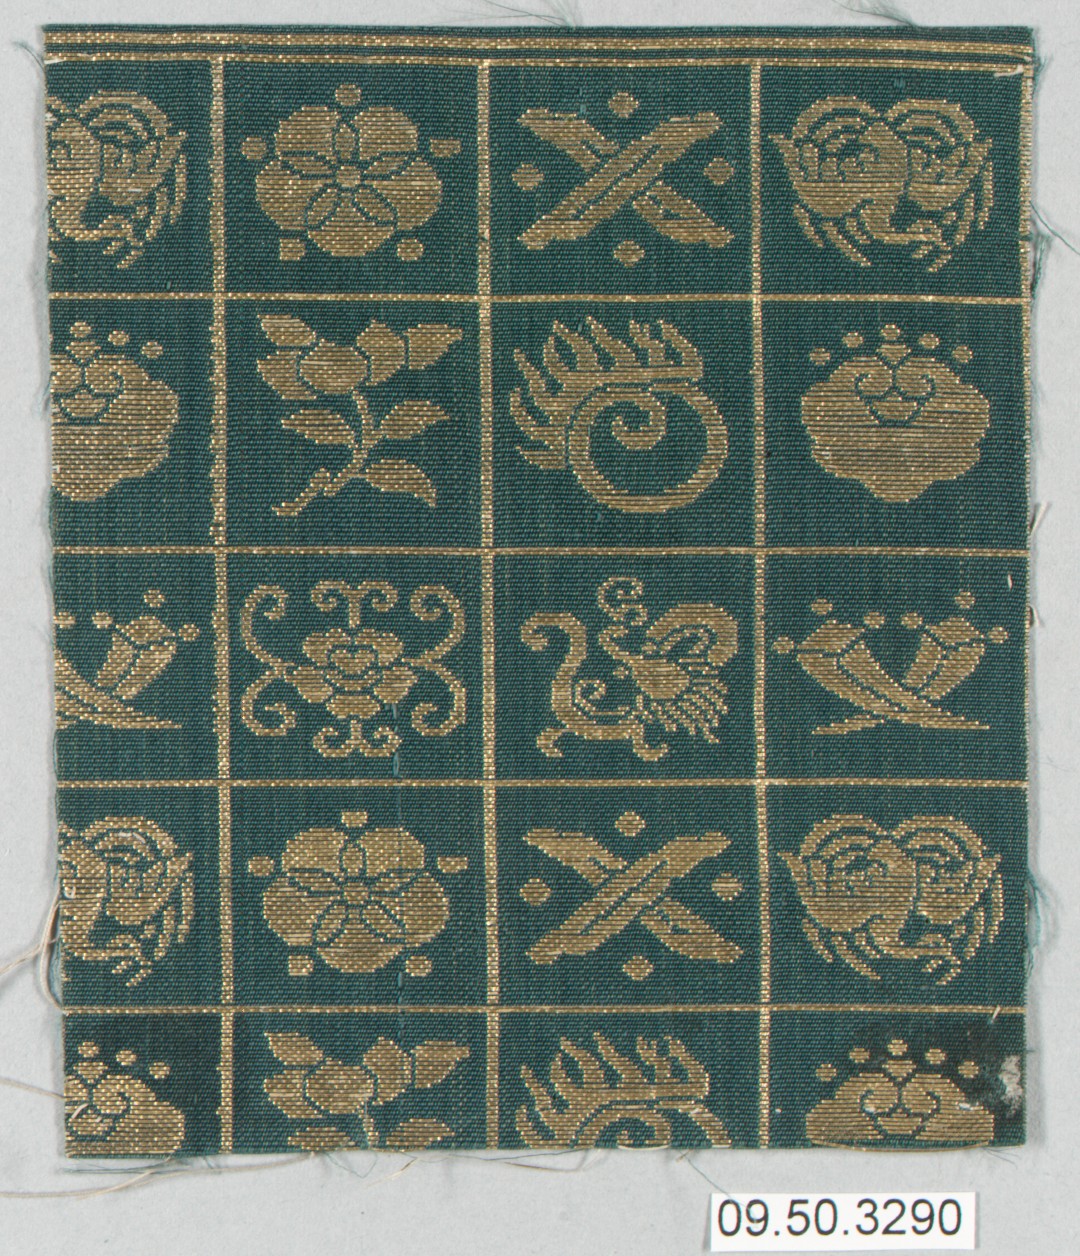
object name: piece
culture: japanese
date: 1801-1900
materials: metal thread, silk